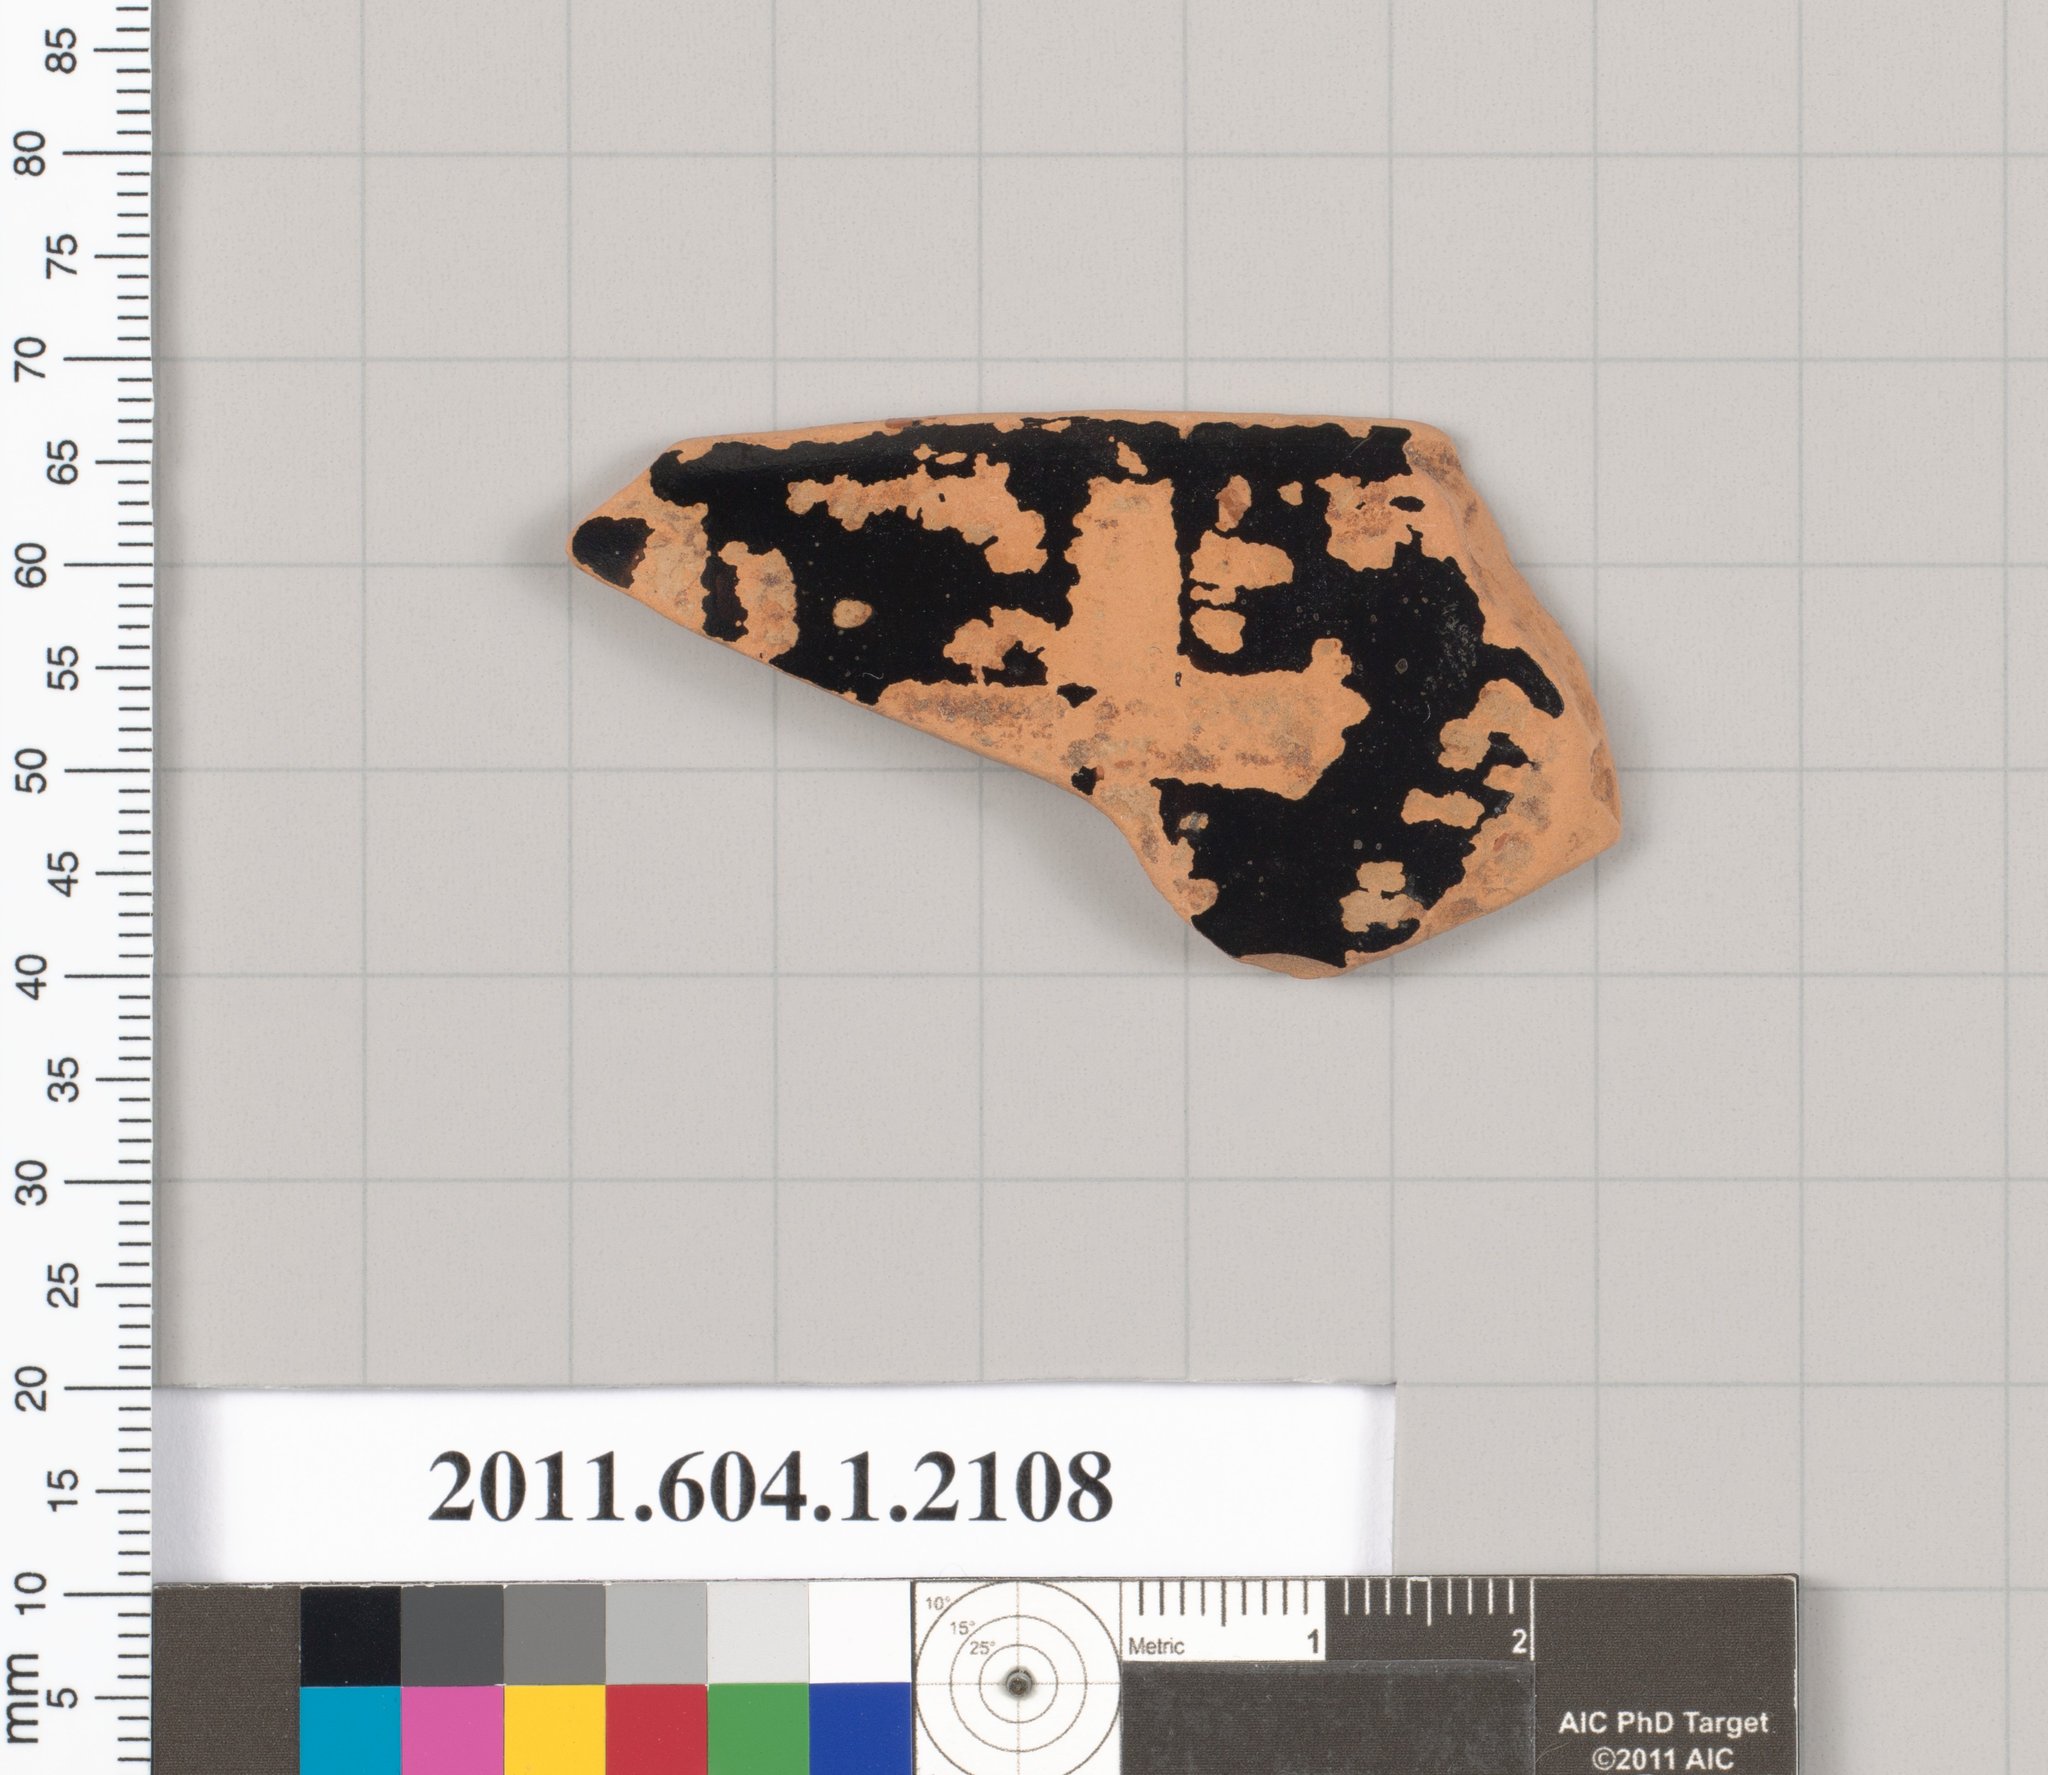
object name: kylix fragment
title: Terracotta rim fragment of a kylix (drinking cup)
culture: greek, attic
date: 500-401 BCE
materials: terracotta